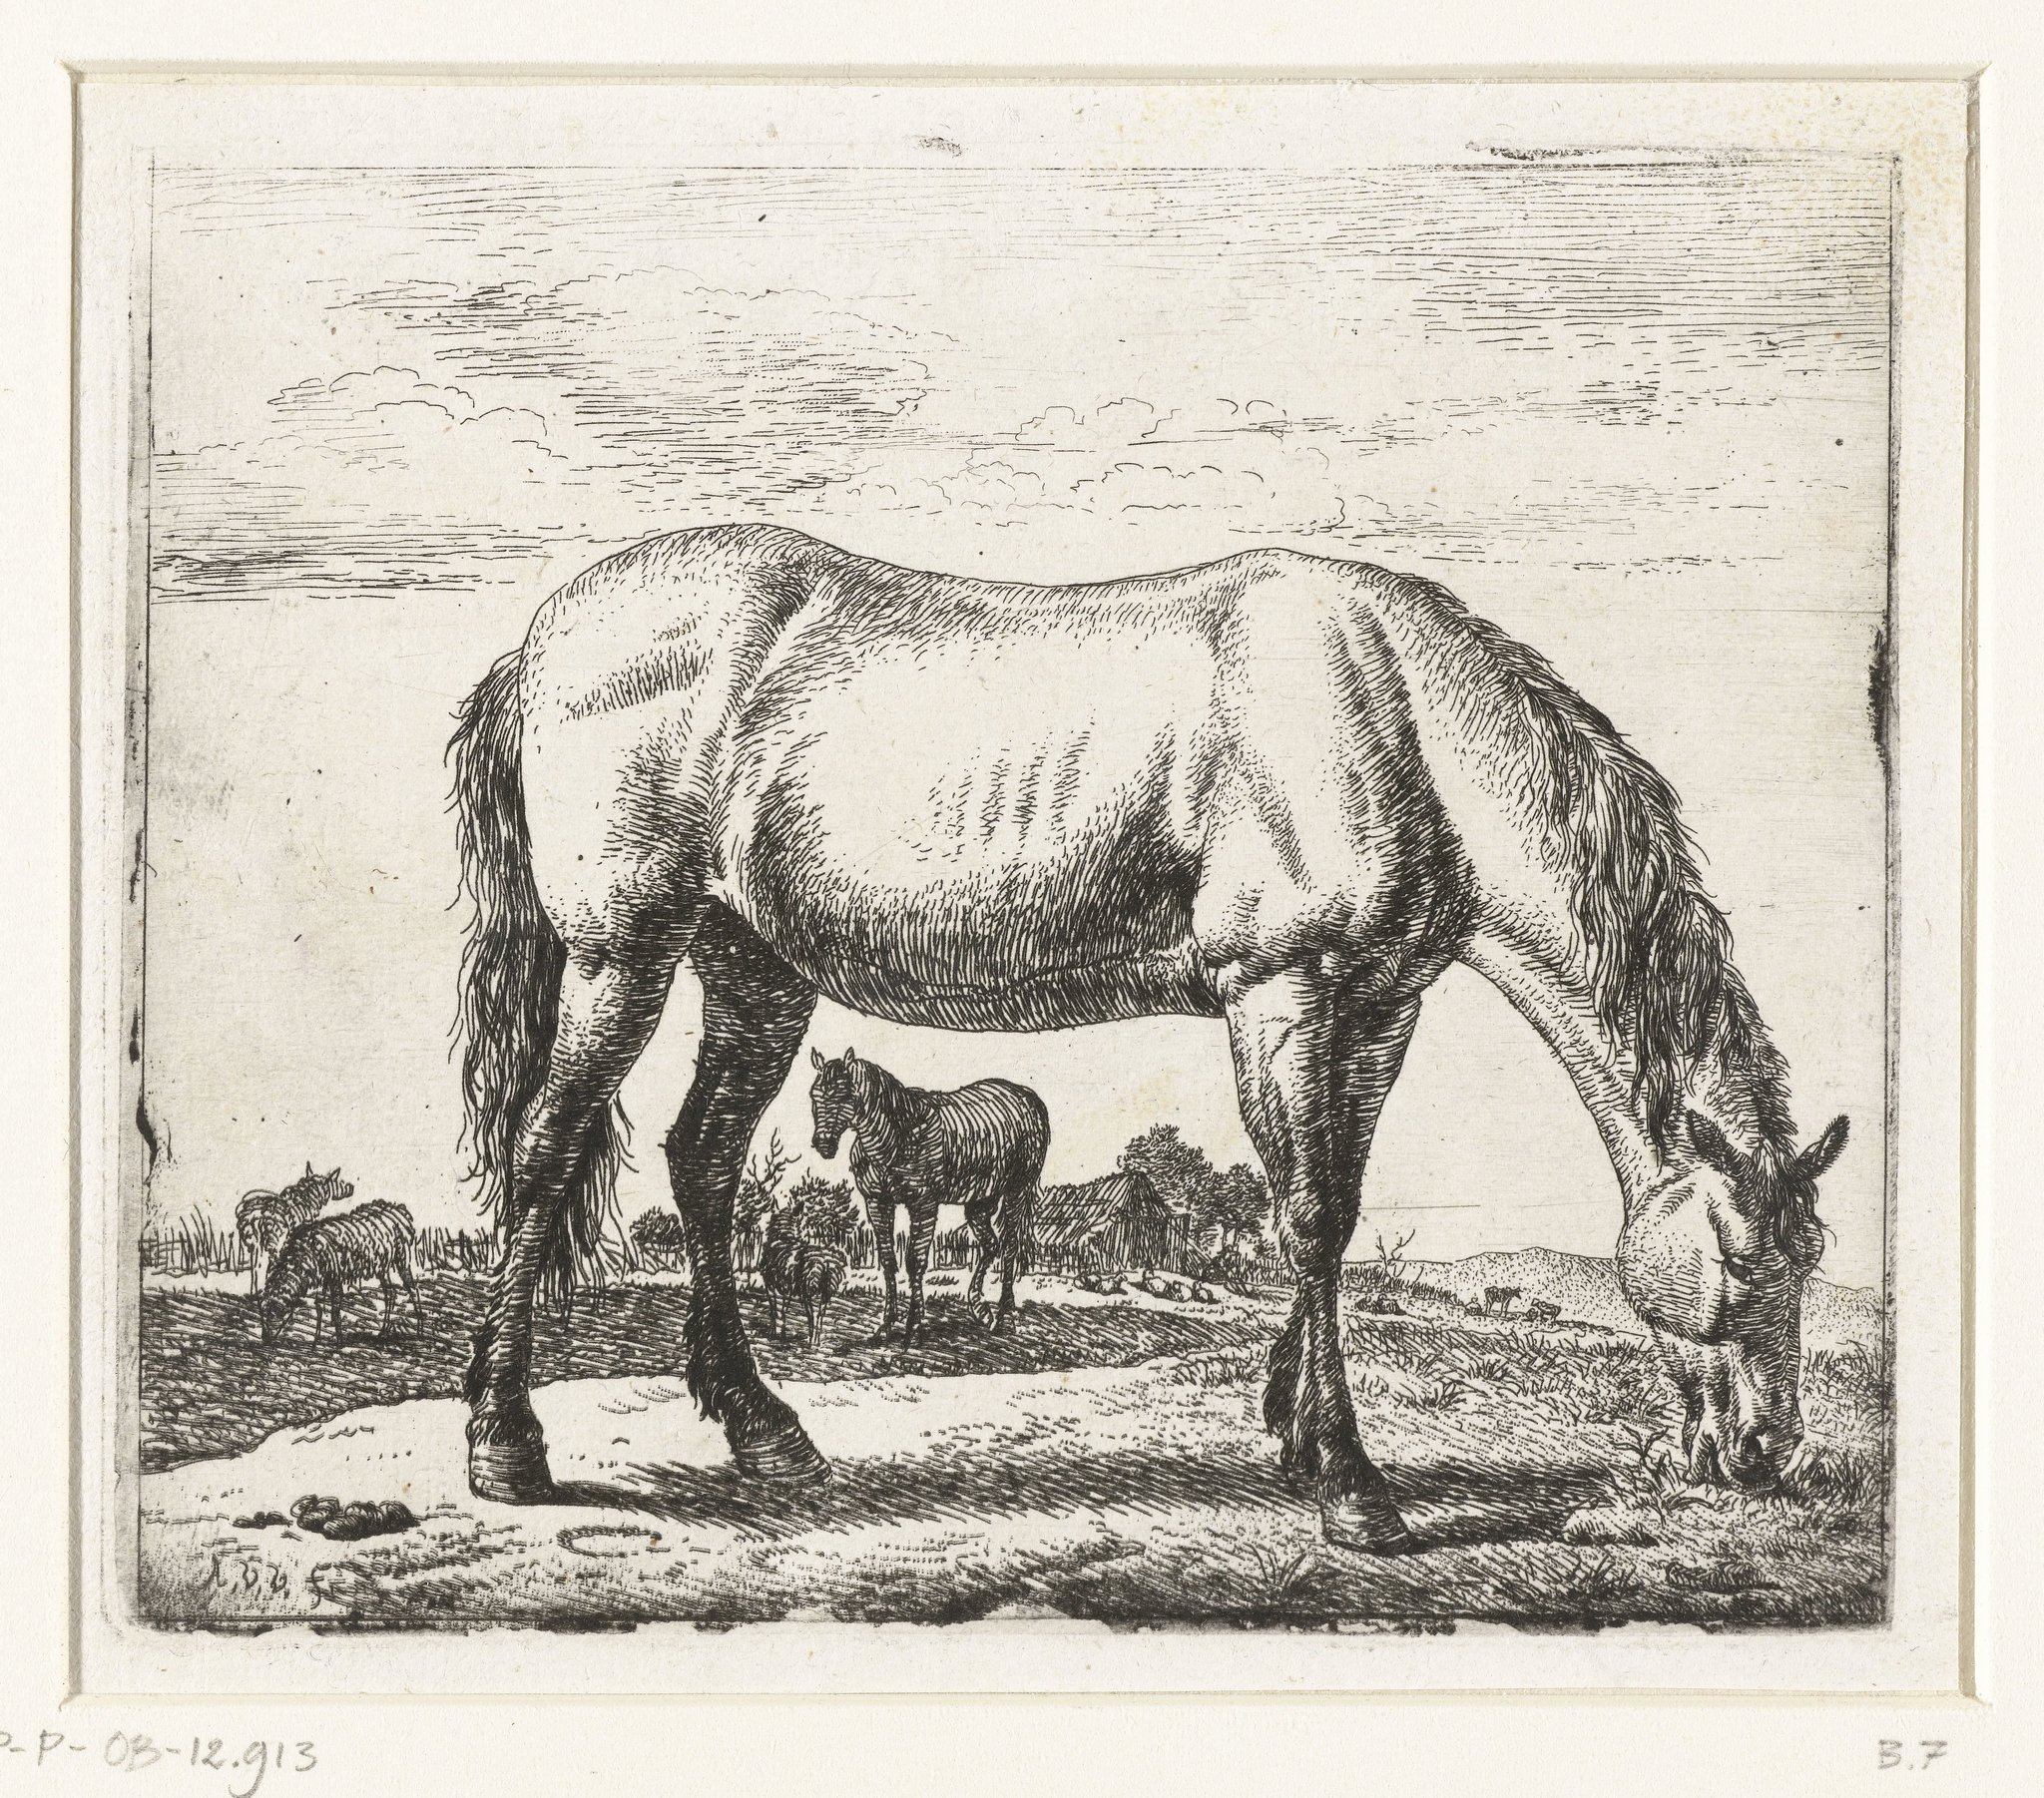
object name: print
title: Grazend paard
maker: adriaen van de velde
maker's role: draughtsman, painter, print maker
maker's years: 1636-1672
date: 1657-1659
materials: paper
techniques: etching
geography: amsterdam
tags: horse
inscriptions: collector's mark: Lugt 240